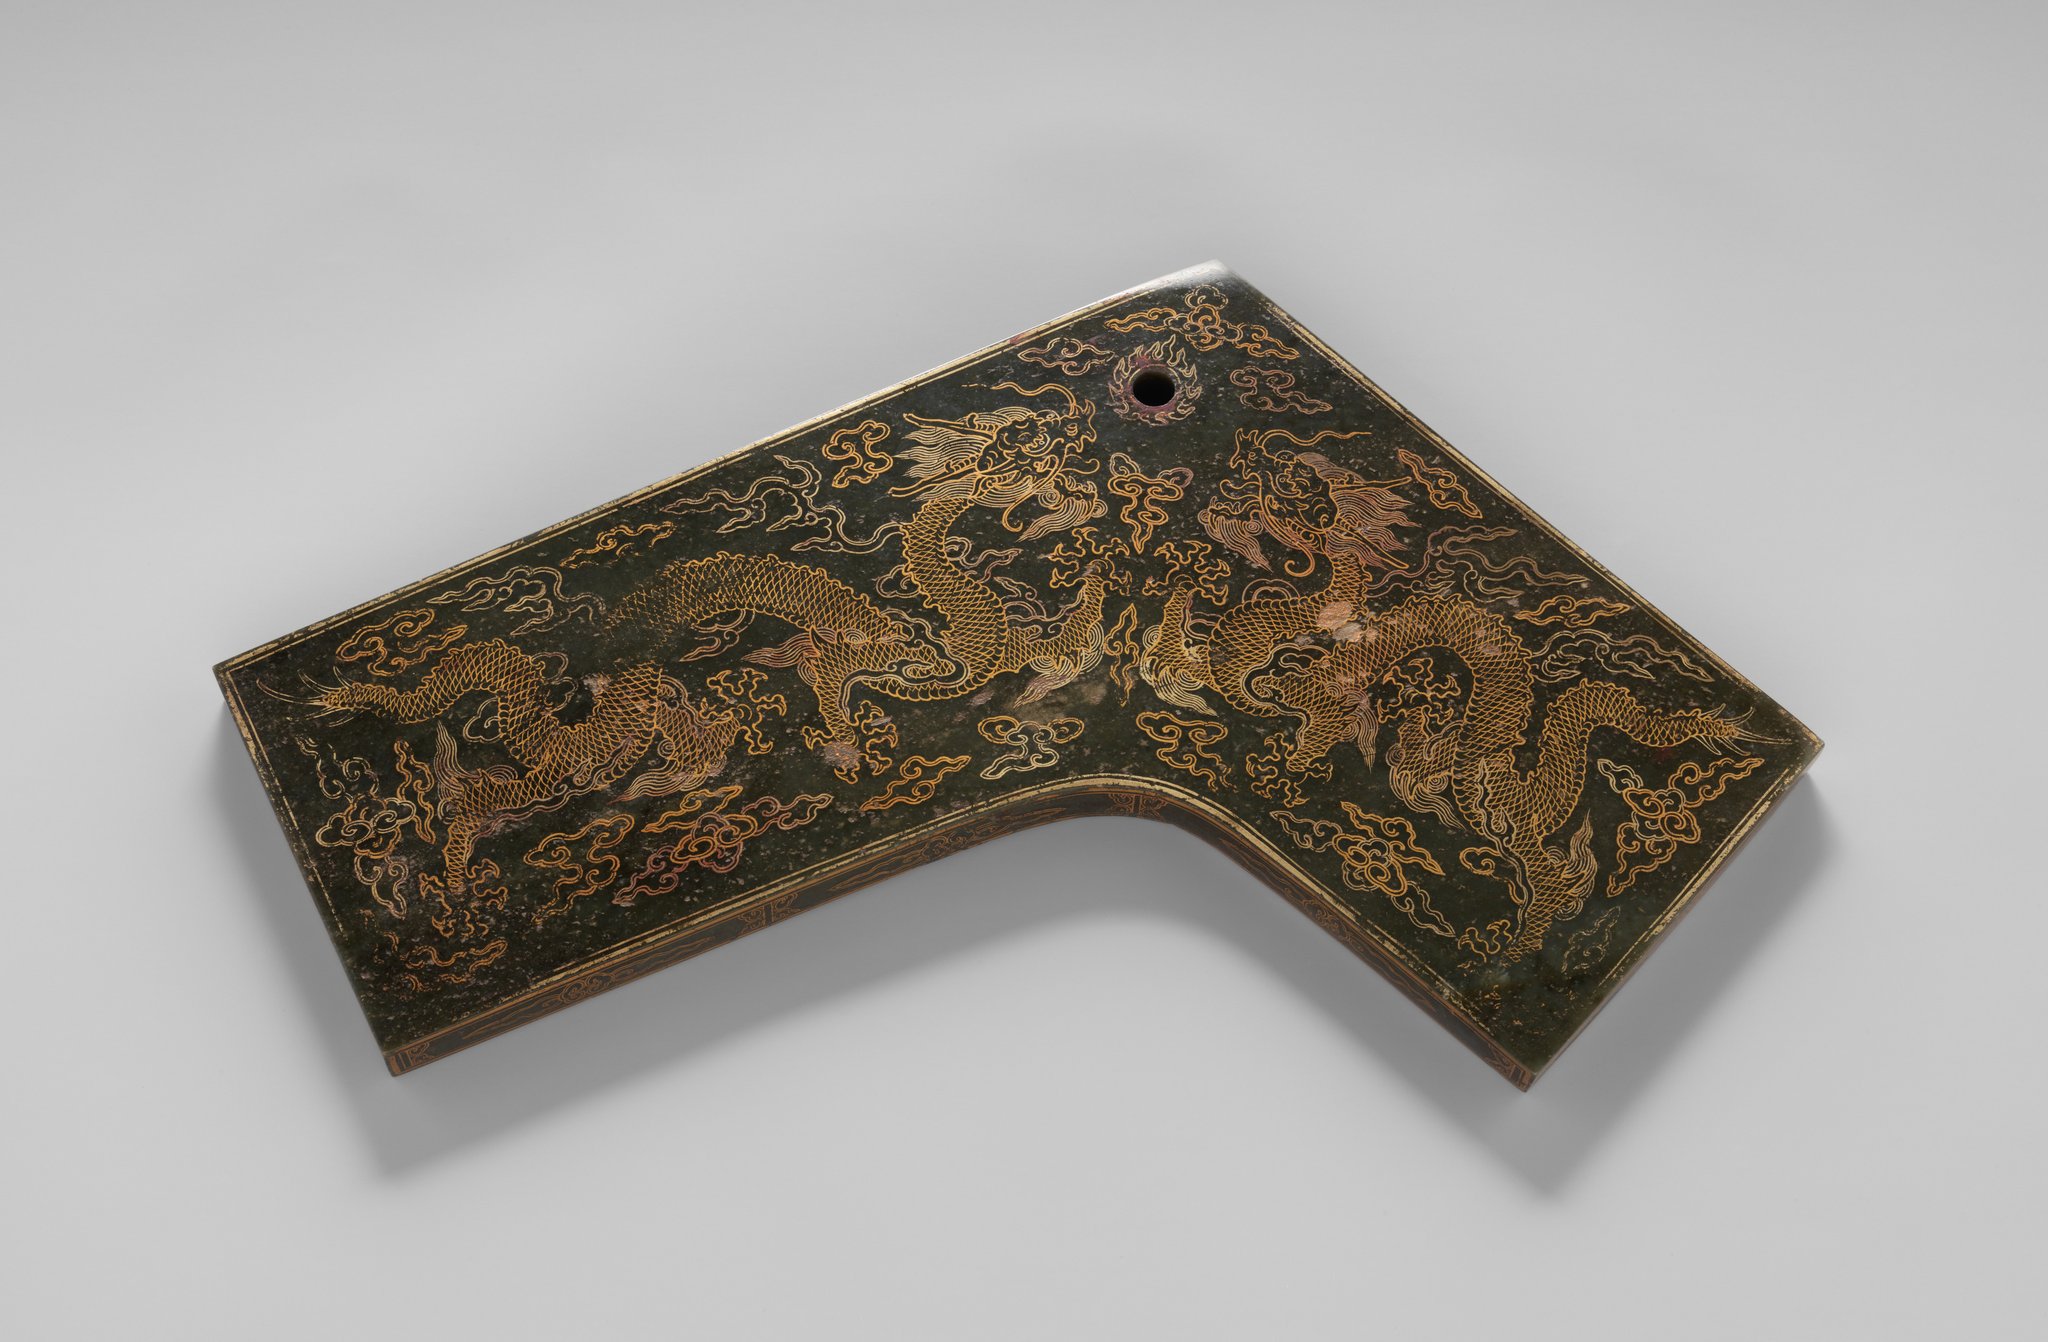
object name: chime qing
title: Chime (Qing) for Linzhong (8th note in the 12-note scale)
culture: chinese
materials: jade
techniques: gilding, incising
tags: dragons